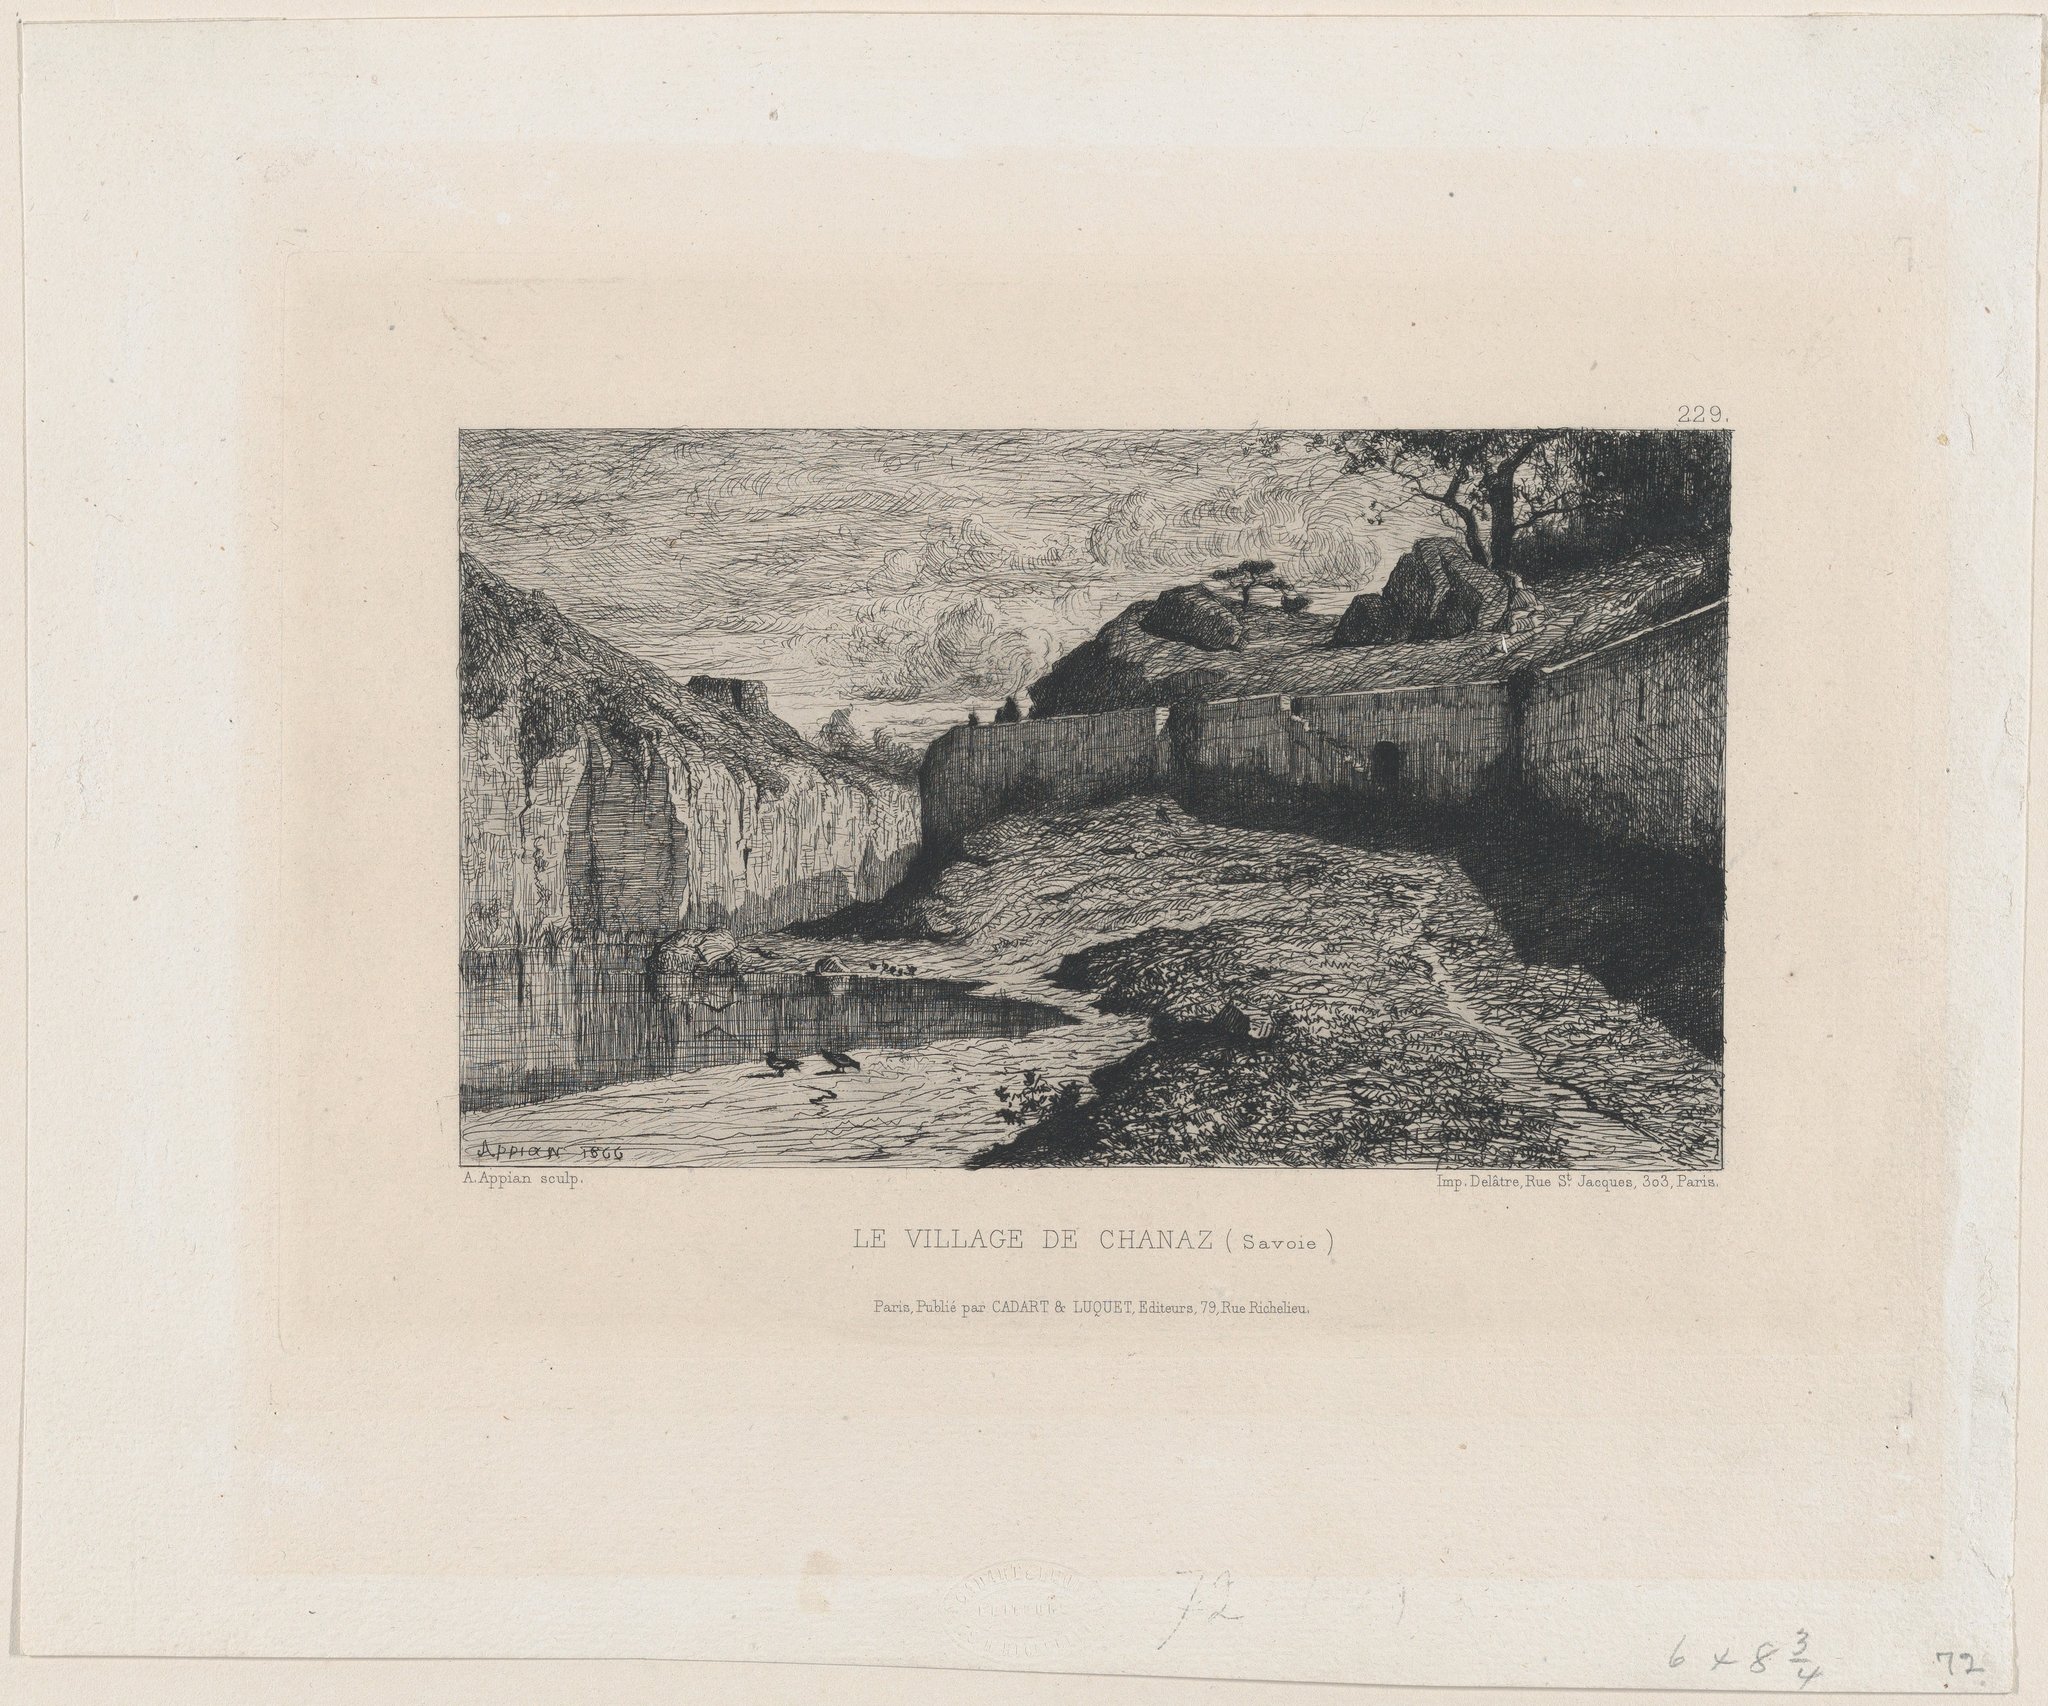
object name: print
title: The Village of Chanaz (Savoie)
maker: adolphe appian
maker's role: artist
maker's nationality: french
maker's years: 1818-1898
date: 1866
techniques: etching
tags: villages,landscapes